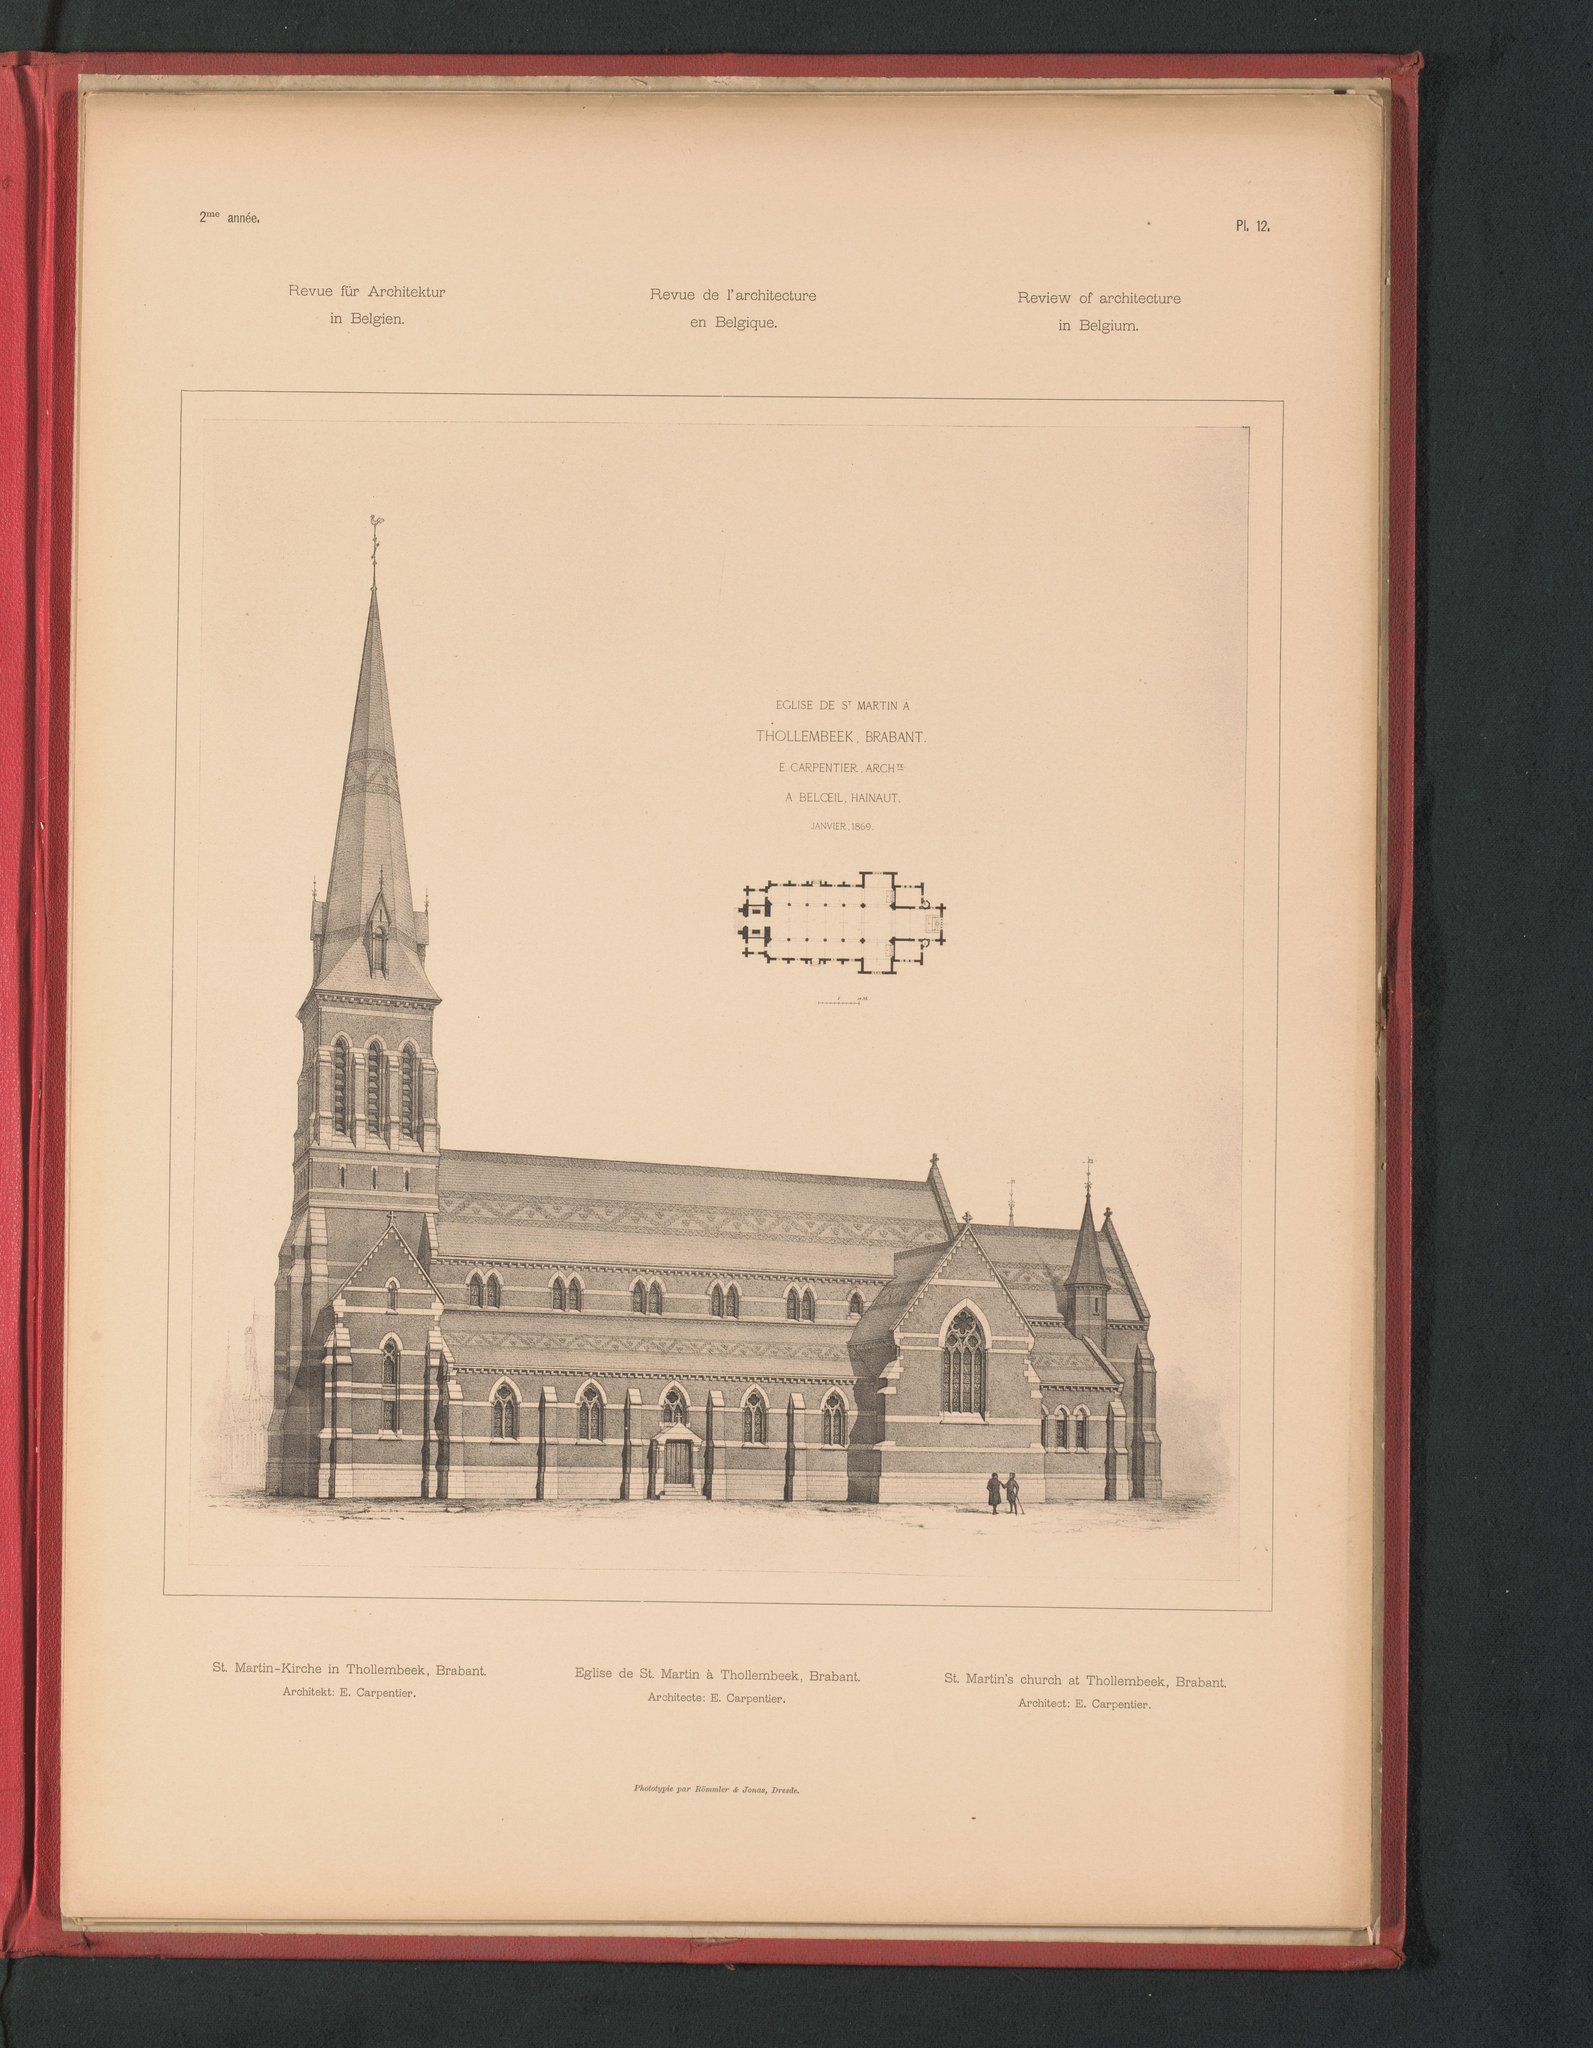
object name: photomechanical print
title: Review of architecture in Belgium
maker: eugène carpentier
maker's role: architect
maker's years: 1819-1886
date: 1888-1893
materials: paper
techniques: photograph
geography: dresden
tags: church (exterior), plan ~ architecture, exterior ~ architectural design or model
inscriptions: inscription: ‘2me. année.’, number: ‘Pl. 12.’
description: Deze prent maakt deel uit van een omslag met 110 prenten op 90 bladen en 18 tekstbladen.